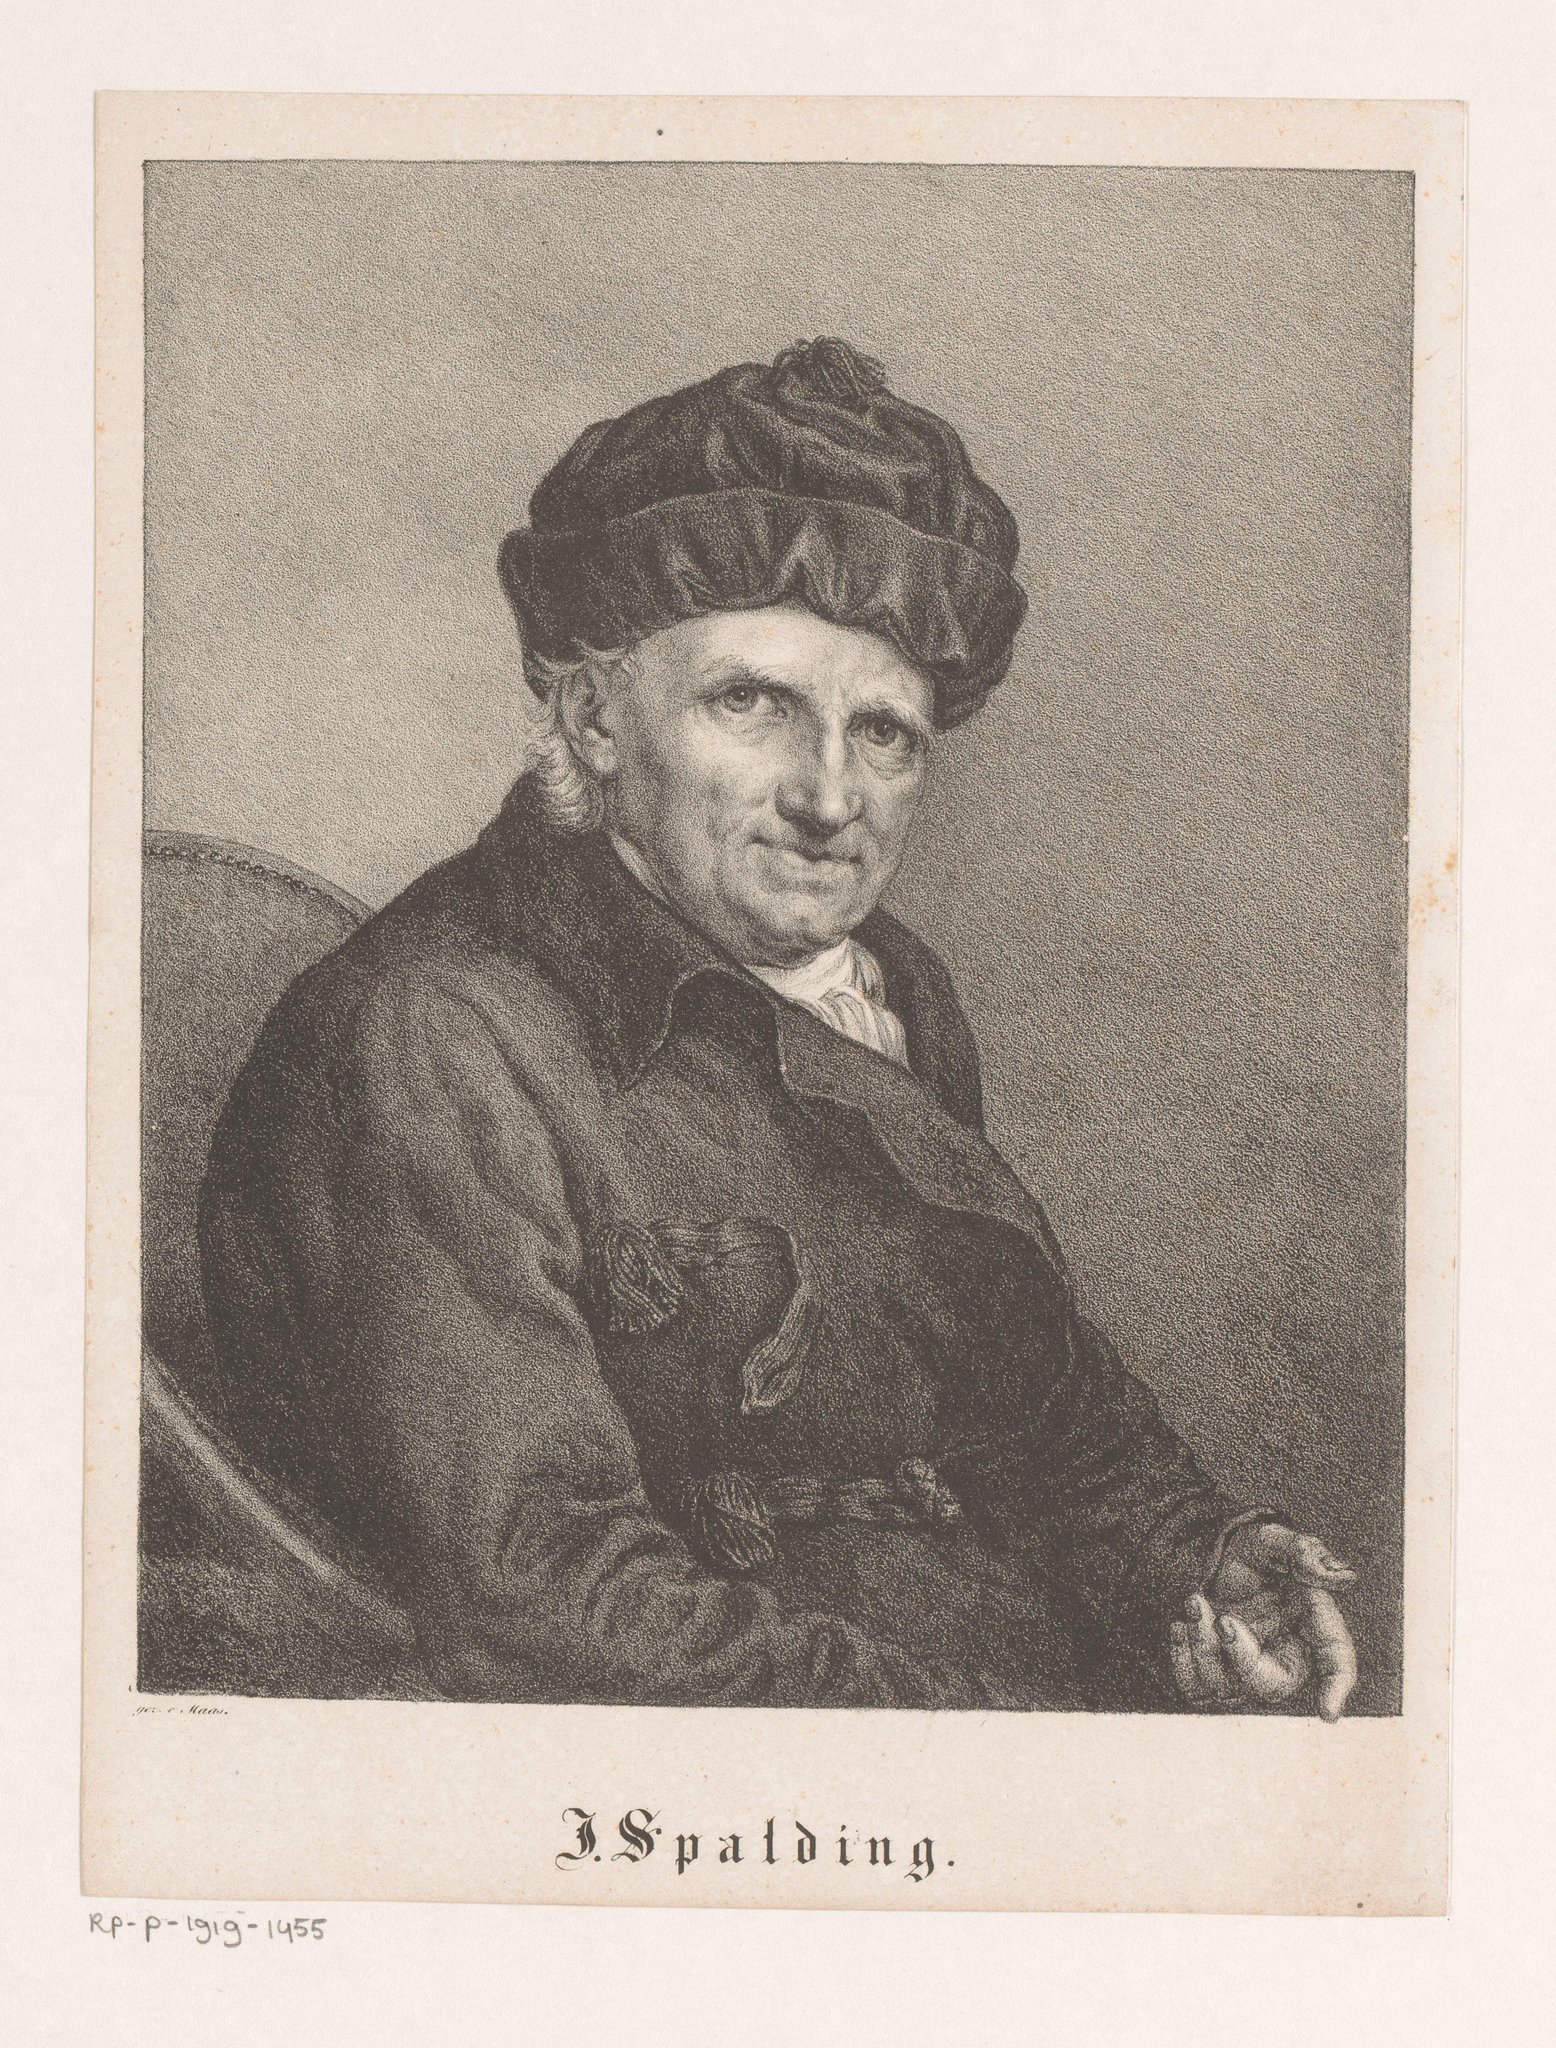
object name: print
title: Portret van Johann Joachim Spalding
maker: maas (graveur)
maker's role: print maker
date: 1809-1899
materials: paper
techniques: lithograph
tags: berlin, johann joachim spalding, head-gear, historical persons (+ (full) bust portrait)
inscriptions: collector's mark: Lugt 2228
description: De geportretteerde draagt een muts. Onder het portret zijn naam.